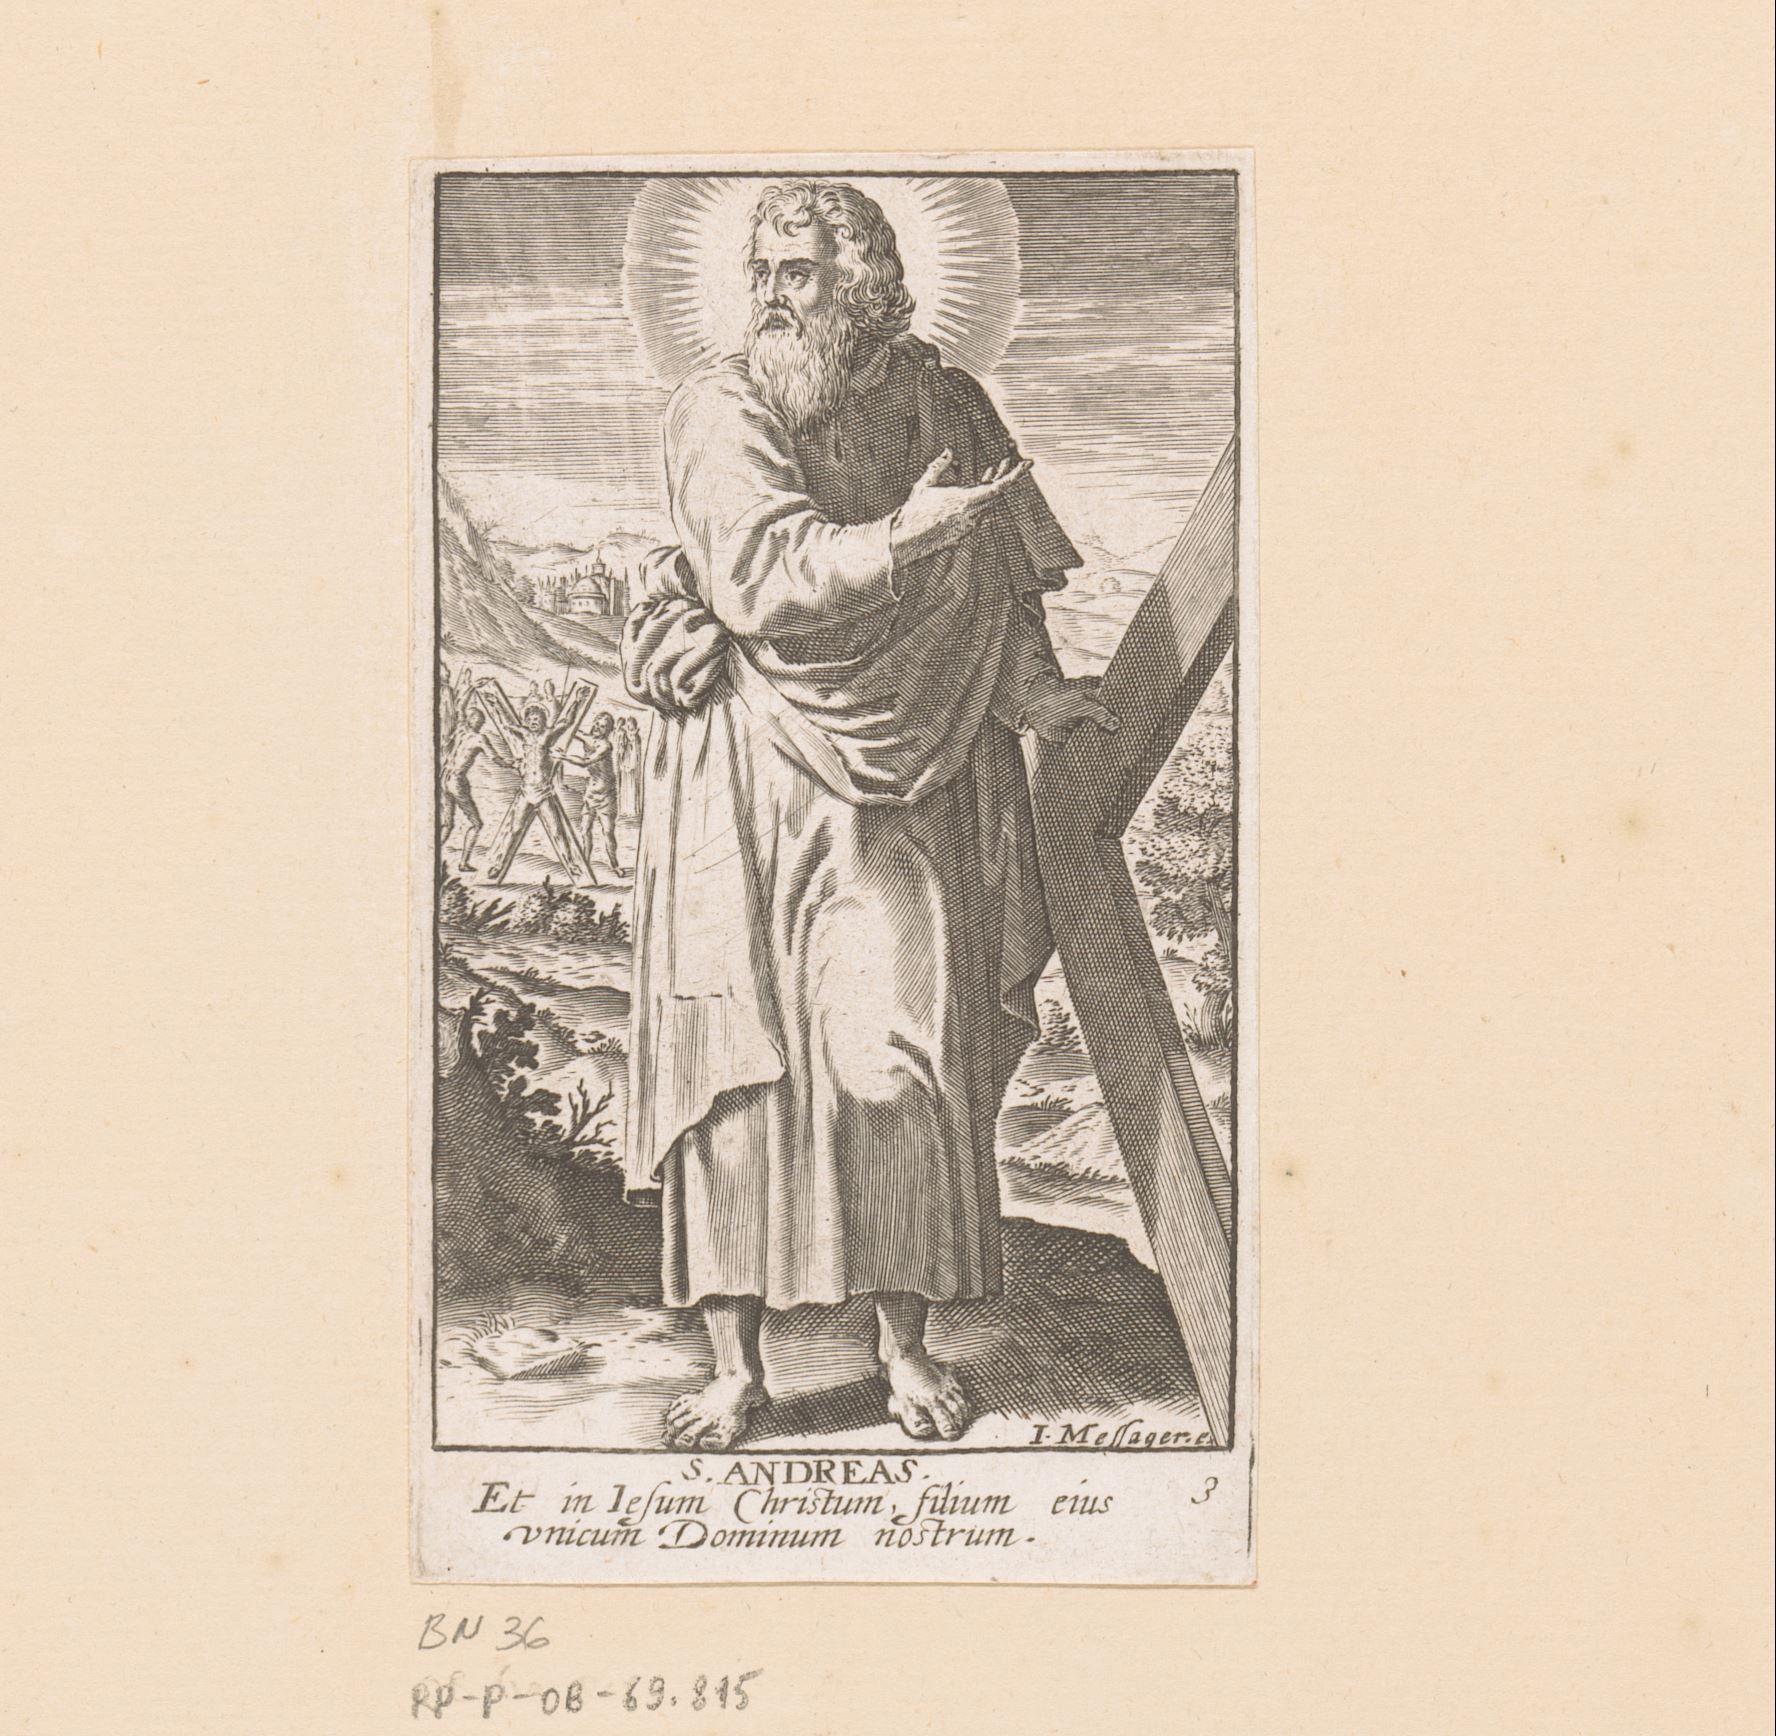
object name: print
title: Staande heiligen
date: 1608-1649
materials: paper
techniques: engraving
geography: france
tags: the apostle andrew; possible attributes: book, x-shaped cross, fish, fishing-net, rope, scroll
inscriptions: collector's mark: Lugt 240